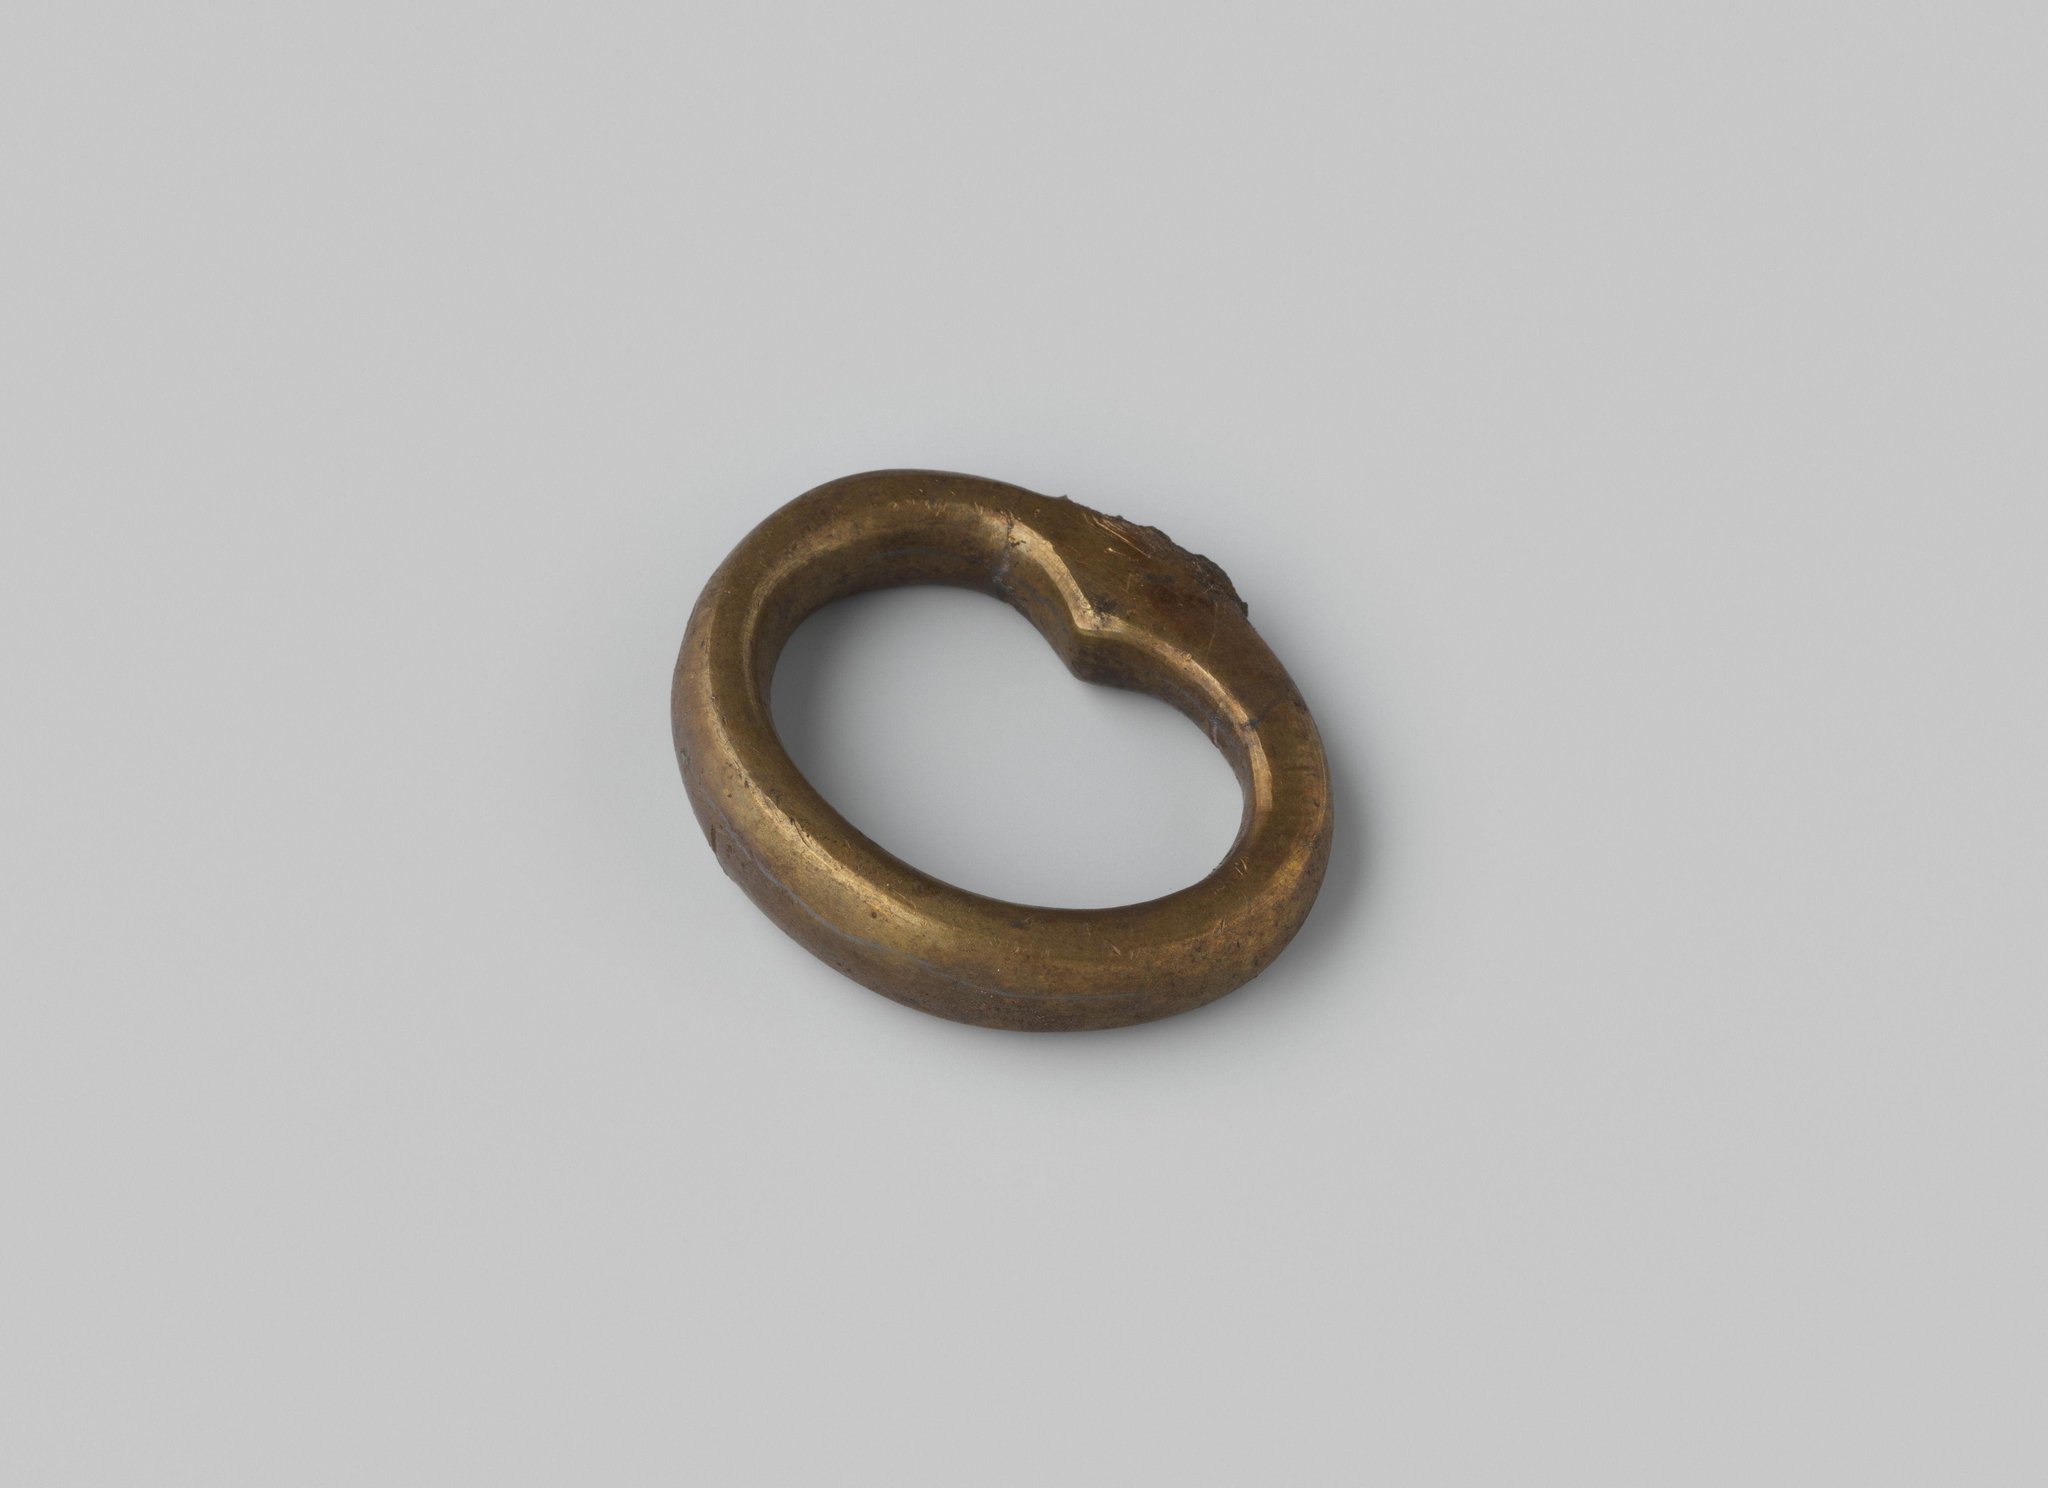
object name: handle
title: Ringhandvat uit het wrak van de Oost-Indiëvaarder Hollandia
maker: Anonymous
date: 1700-1743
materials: copper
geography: netherlands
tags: verenigde oostindische compagnie, hollandia (schip), annet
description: Fittings, handles, loop handle; fragm, id. NG 1979-223H2806: ring.